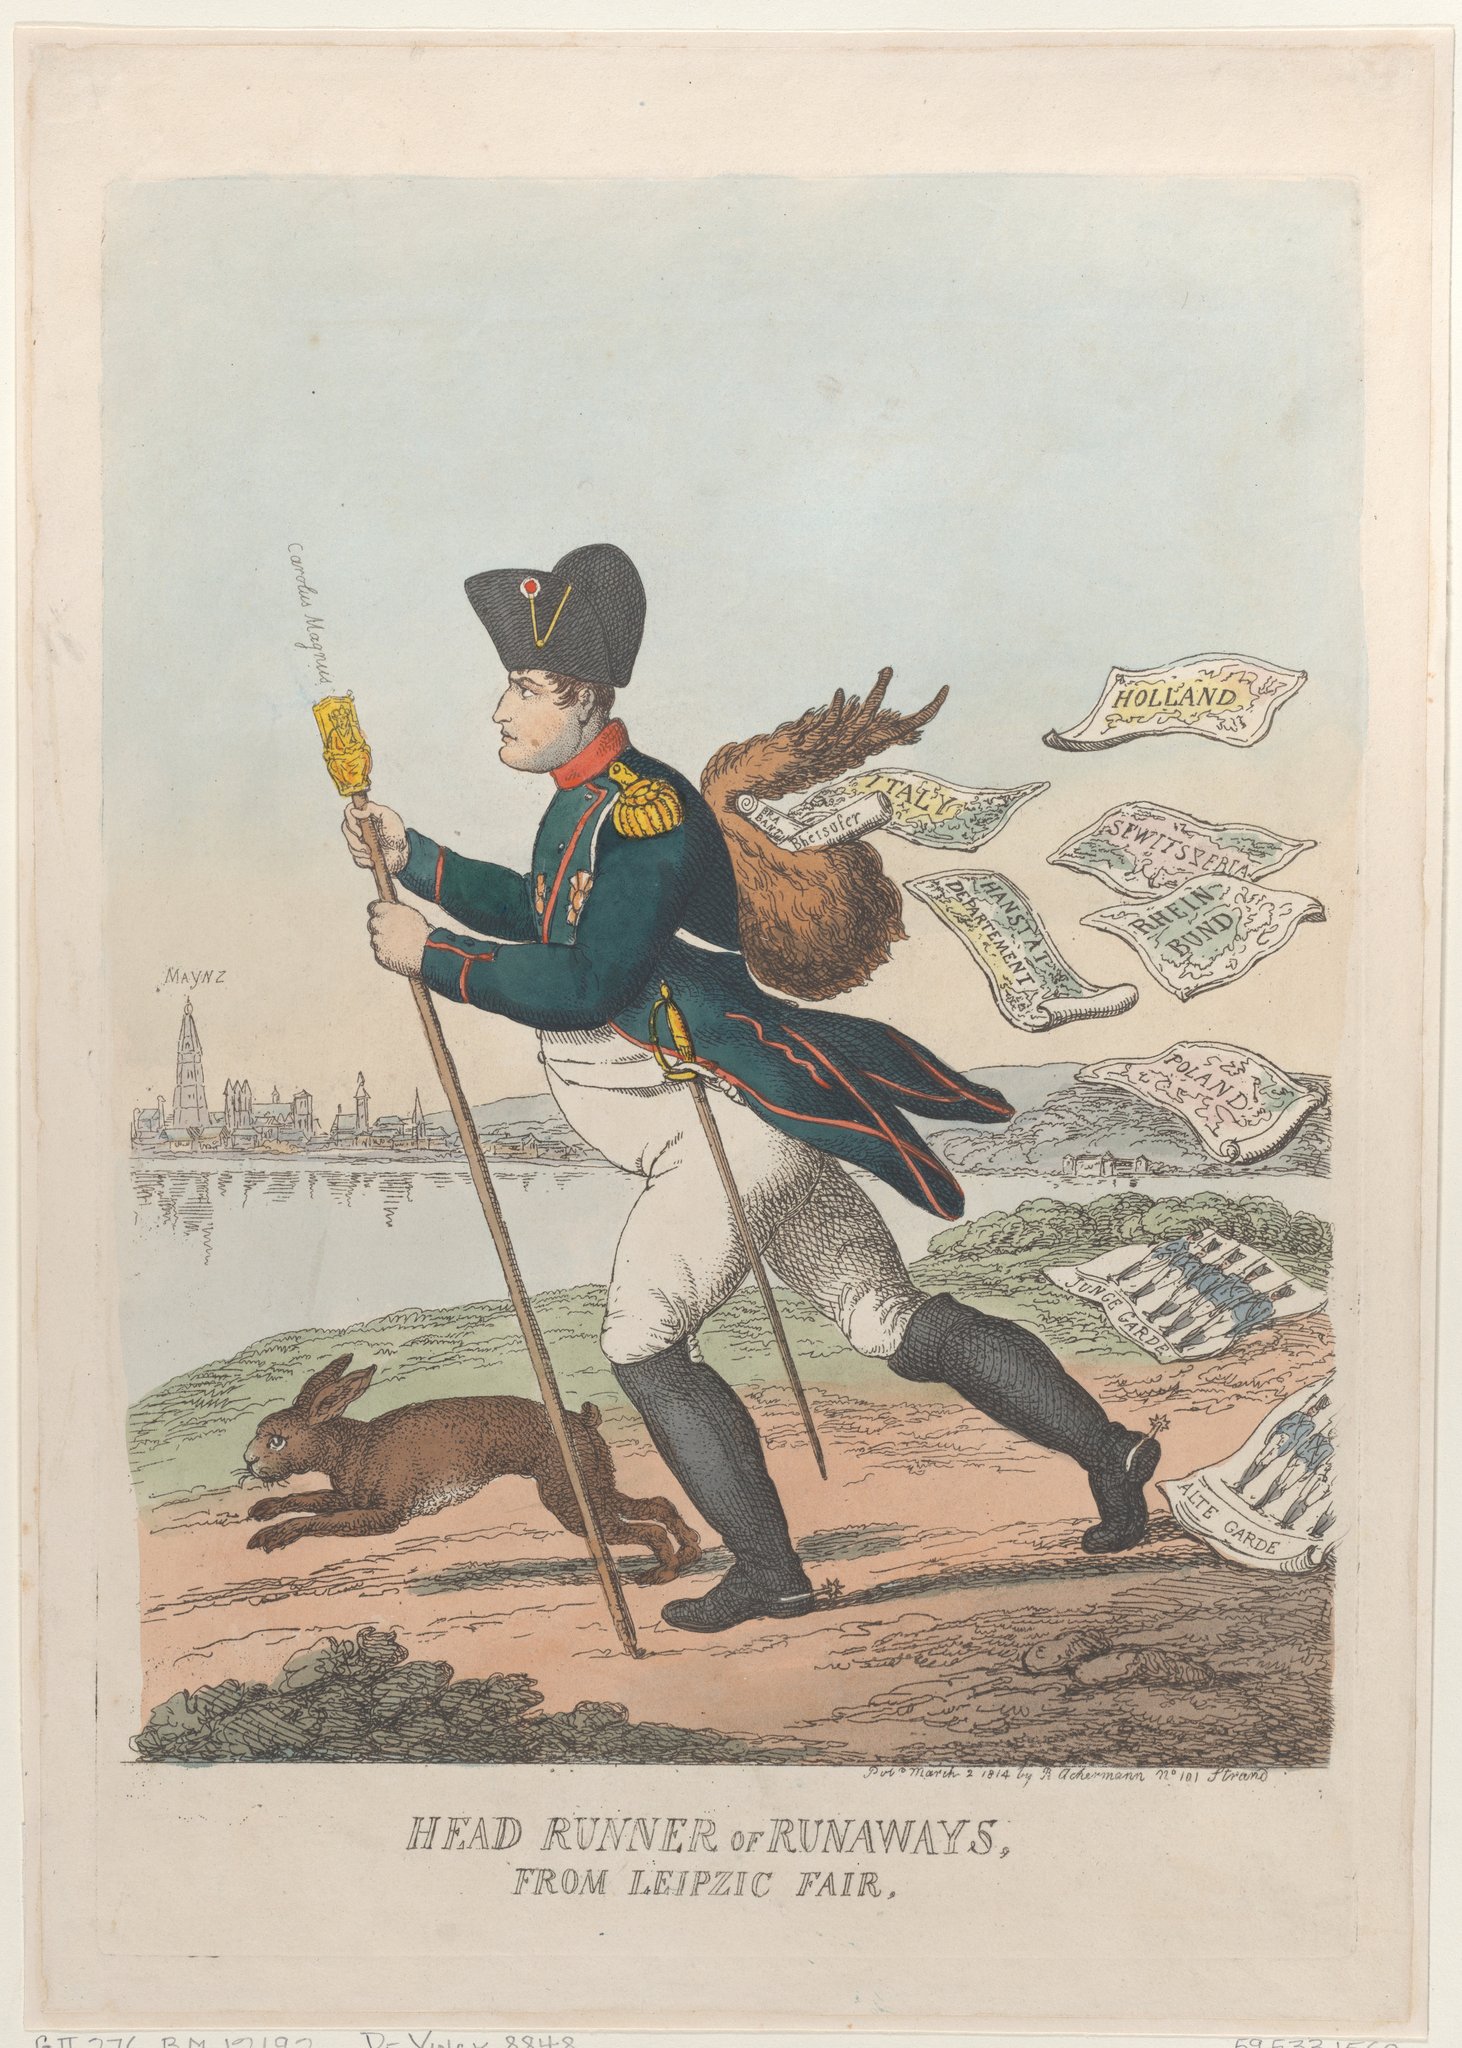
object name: print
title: Head Runner or Runaways from the Leipzic Fair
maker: thomas rowlandson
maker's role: artist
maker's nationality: british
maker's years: 1757-1827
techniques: etching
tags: satire,napoleon i,men,rabbits,politics